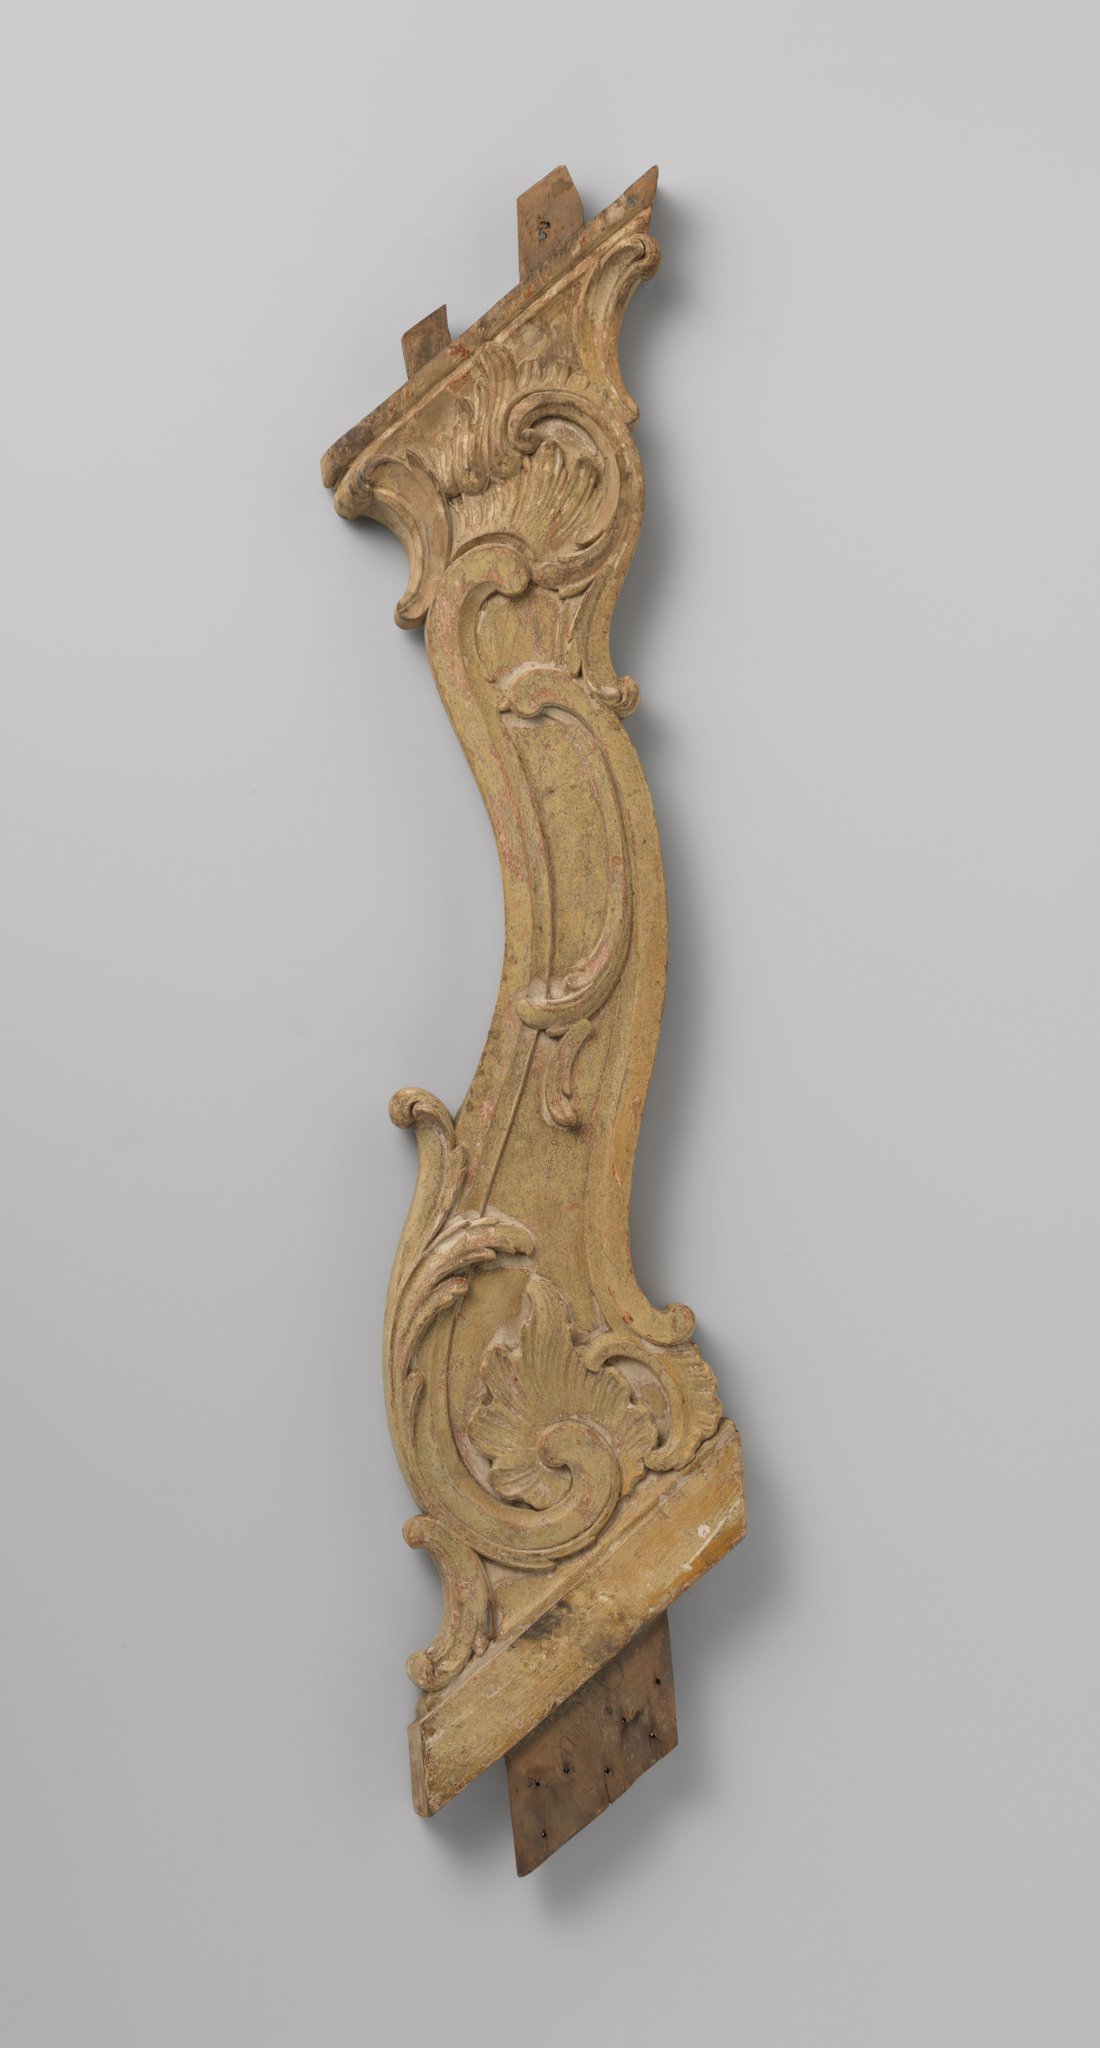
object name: railing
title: Baluster met gestoken C- en S-voluten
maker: Anonymous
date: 1740-1760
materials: wood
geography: northern netherlands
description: S-vormige baluster met gestoken C- en S-voluten met rocaille-schelpen.